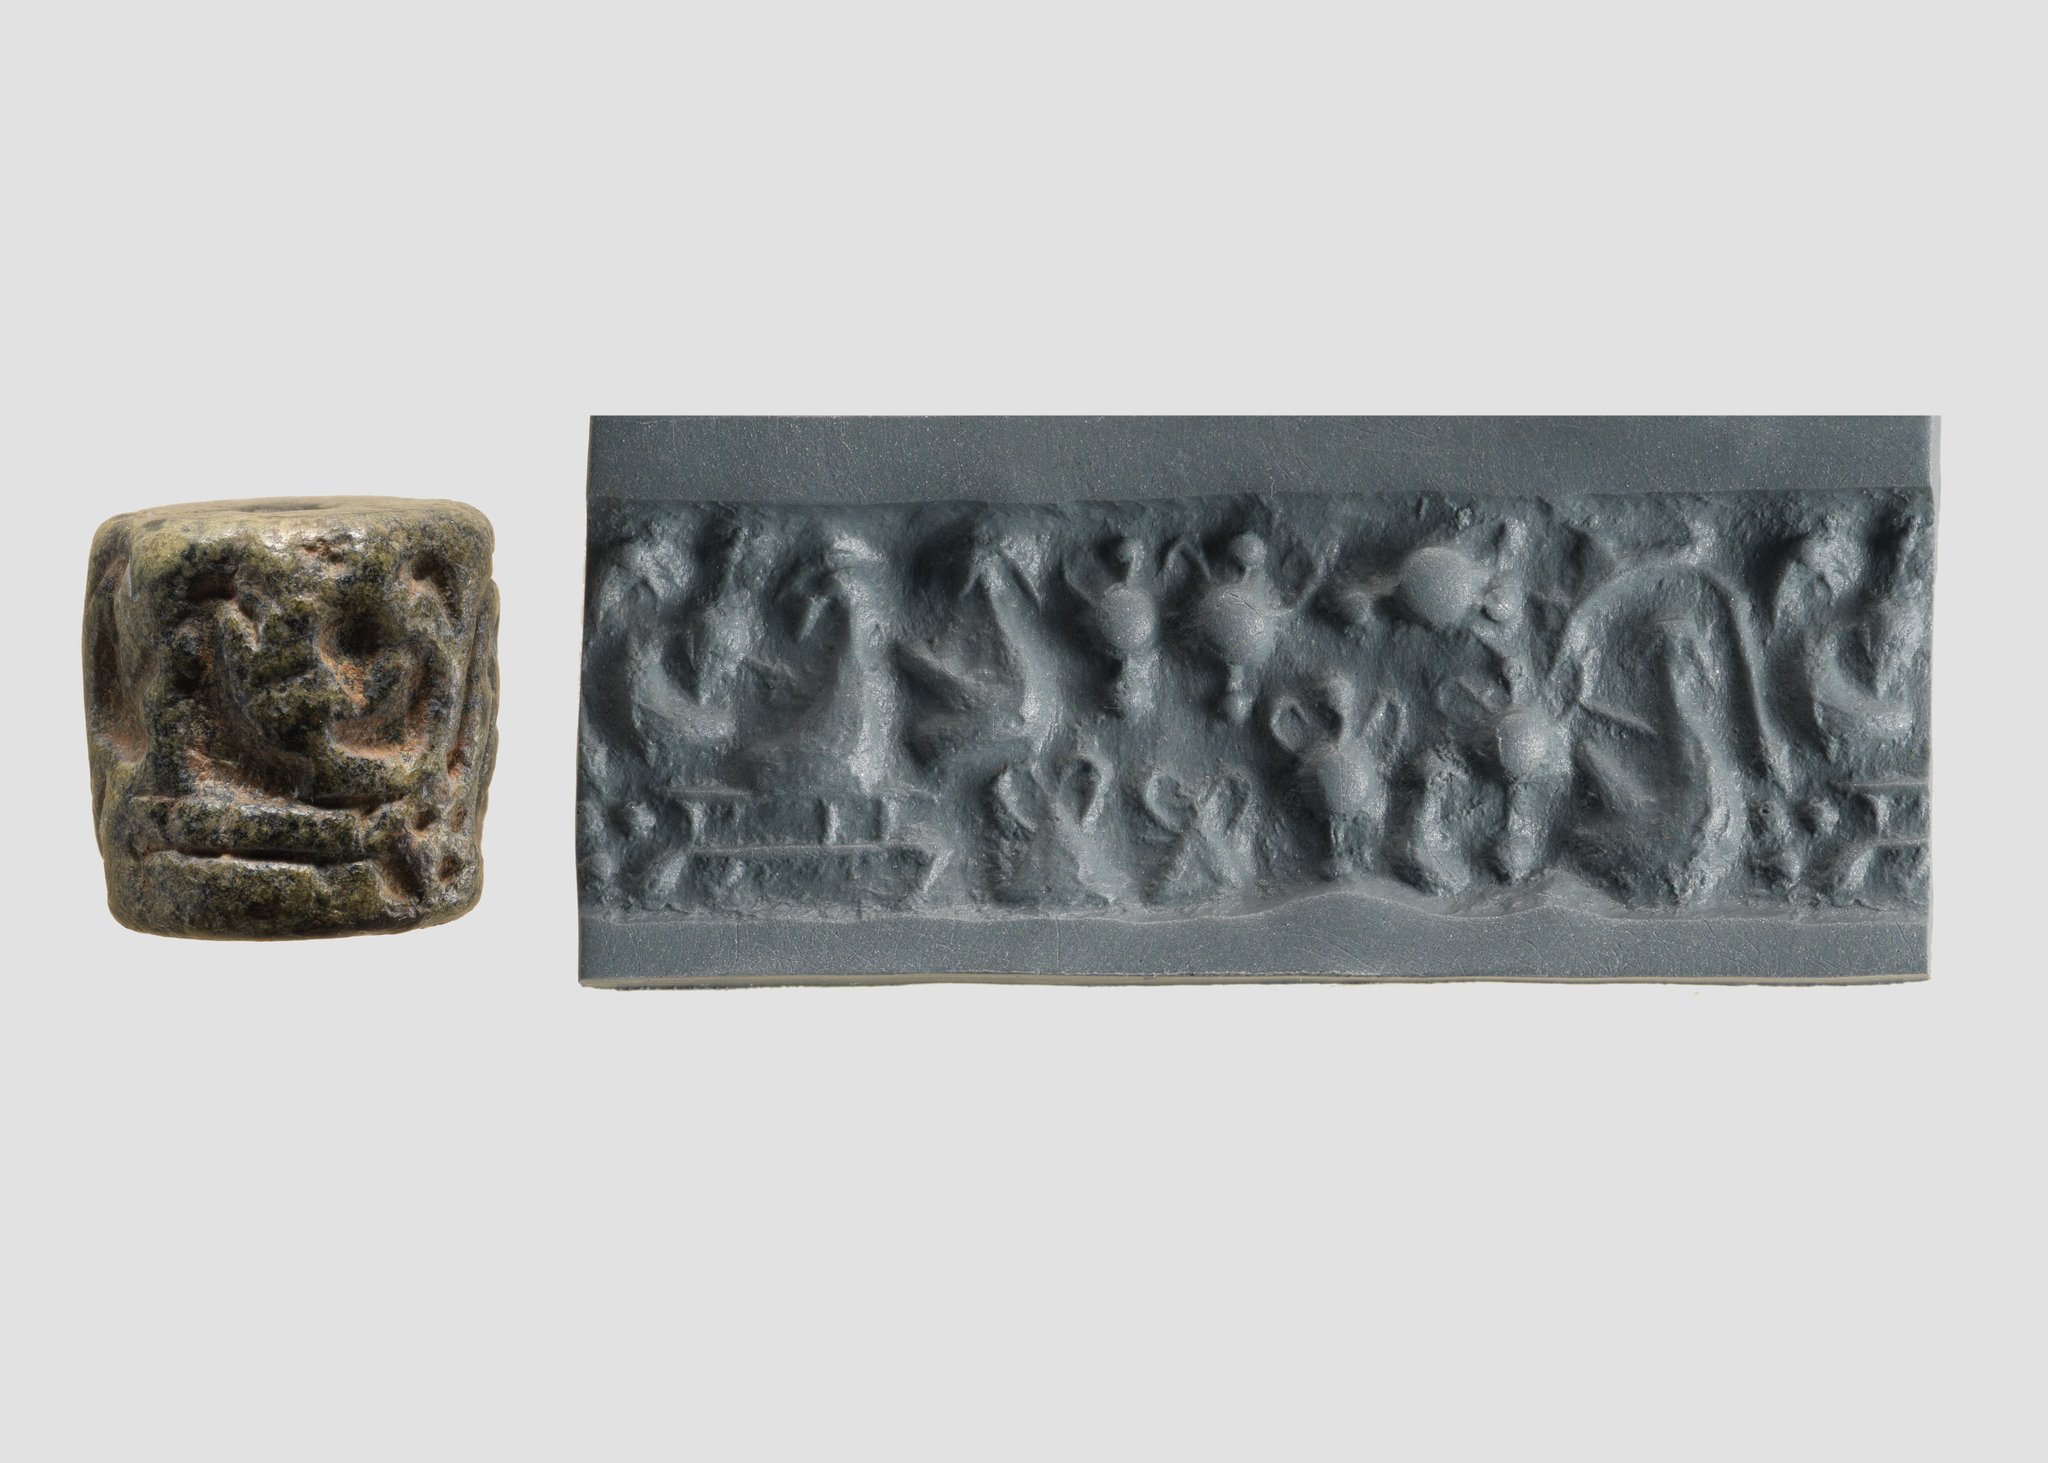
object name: cylinder seal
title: Cylinder seal and modern impression: female figure seated on a platform with "pigtailed ladies" and pots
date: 3300-2900 BCE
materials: mineral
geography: southern mesopotamia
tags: women